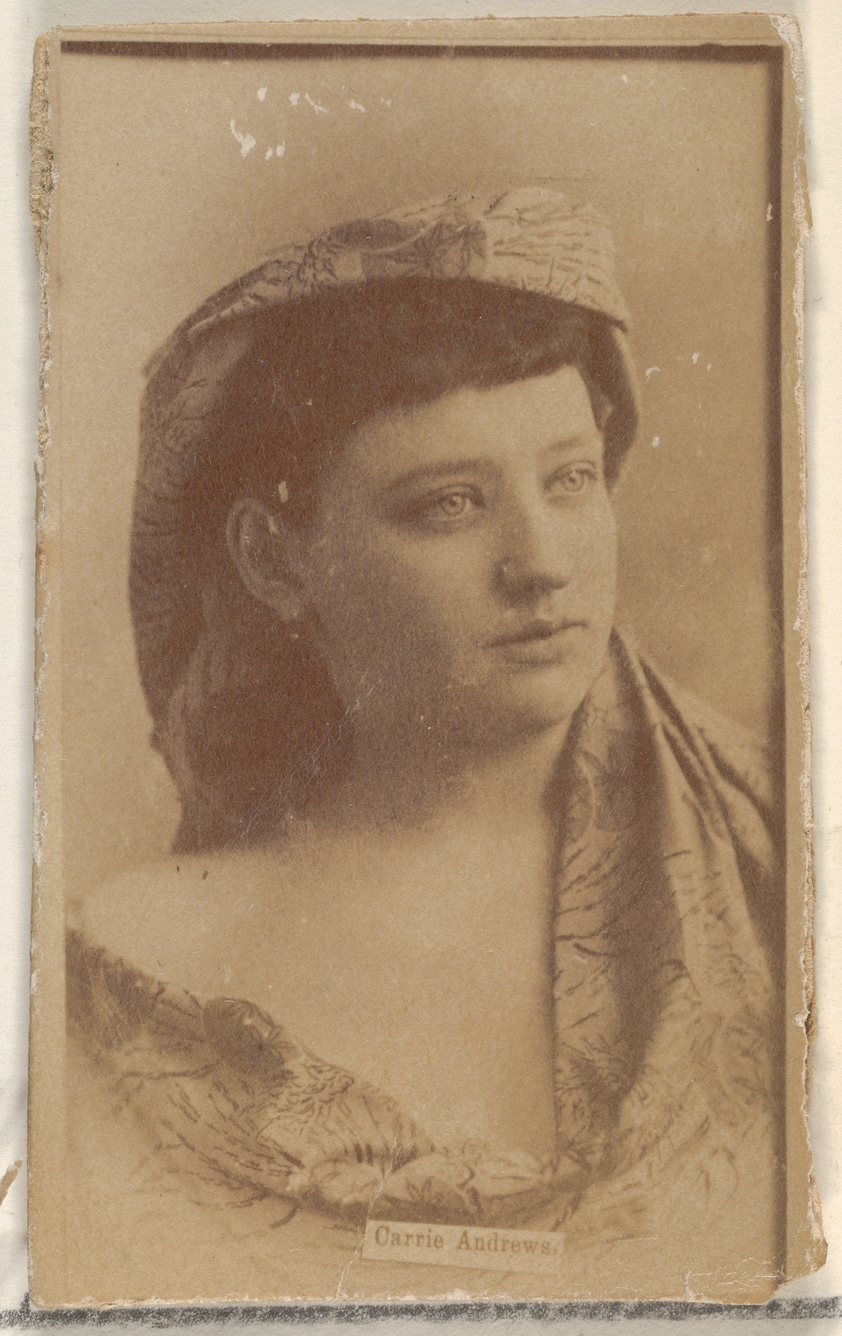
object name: photograph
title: Carrie Andrews, from the Actors and Actresses series (N45, Type 1) for Virginia Brights Cigarettes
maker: allen & ginter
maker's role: publisher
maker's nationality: american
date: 1888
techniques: albumen silver print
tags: portraits,women,actresses